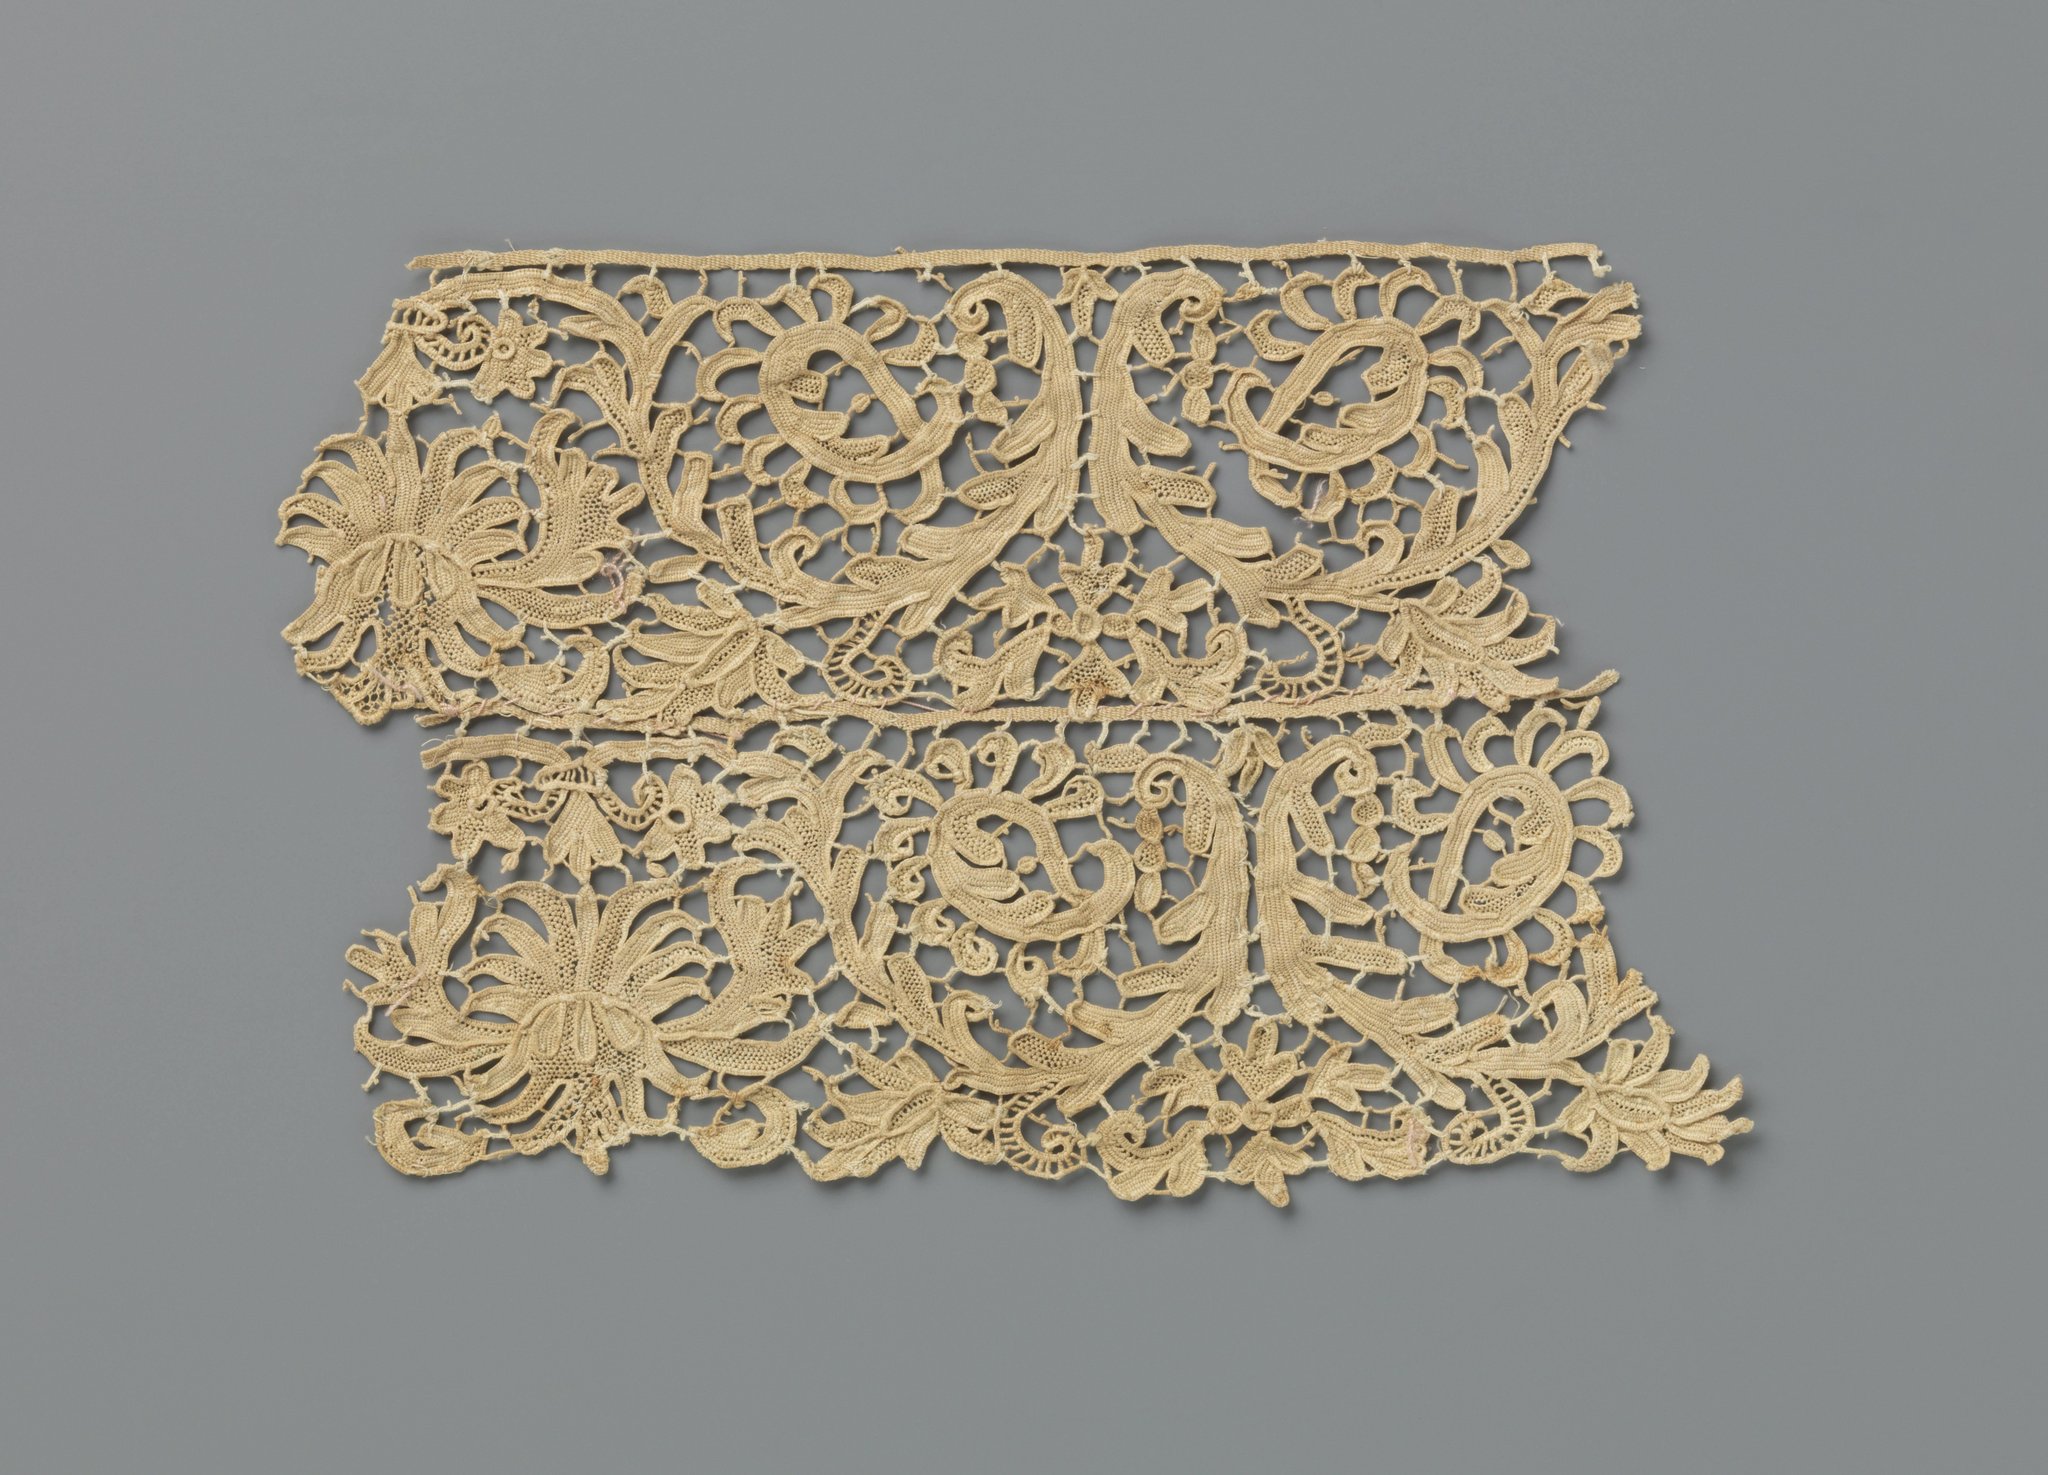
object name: strip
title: Strook bruine naaldkant bestaande uit twee aan elkaar genaaide stroken met een keizerskroonachtige bloem tussen acanthusbladeren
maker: Anonymous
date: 1872-1899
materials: linen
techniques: needle lace, spindle ground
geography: burano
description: Strook bruine naaldkant. De strook bestaat uit twee aan elkaar genaaide stroken, waardoor de strook zich in de breedte heeft verdubbeld. Het patroon van elk van de aan elkaar genaaide stroken bestaat uit een keizerskroonachtige bloem tussen acanthusbladeren en aan de rechterzijde geflankeerd door een strookbreedte vullende, liggende c-voluut. De c-voluut wordt door een smal acanthusblad gevormd en omvat een lusvormige bloem met maanvormige bloemblaadjes. Dit c-voluut herhaald zich in gespiegelde vorm en het patroon wordt dan verbroken. Het oorspronkelijke patroon is symmetrisch en herhaalt zich. Zie voor het complete patroon: BK-1973-87-A. De motieven zijn gemaakt met festonsteken en voorzien van lichte reliëfcontouren. De motieven zijn met elkaar verbonden door een spaarzaam gepicoteerde spijlengrond. De bovenzijde van beide stroken zijn recht afgewerkt, waarbij de rechte bovenzijde van de onderste strook aan de flauwe schulpenrand van de bovenste strook is genaaid. De flauwe schulpenrand aan de onderzijde van de stroken komen voort uit het patroon.